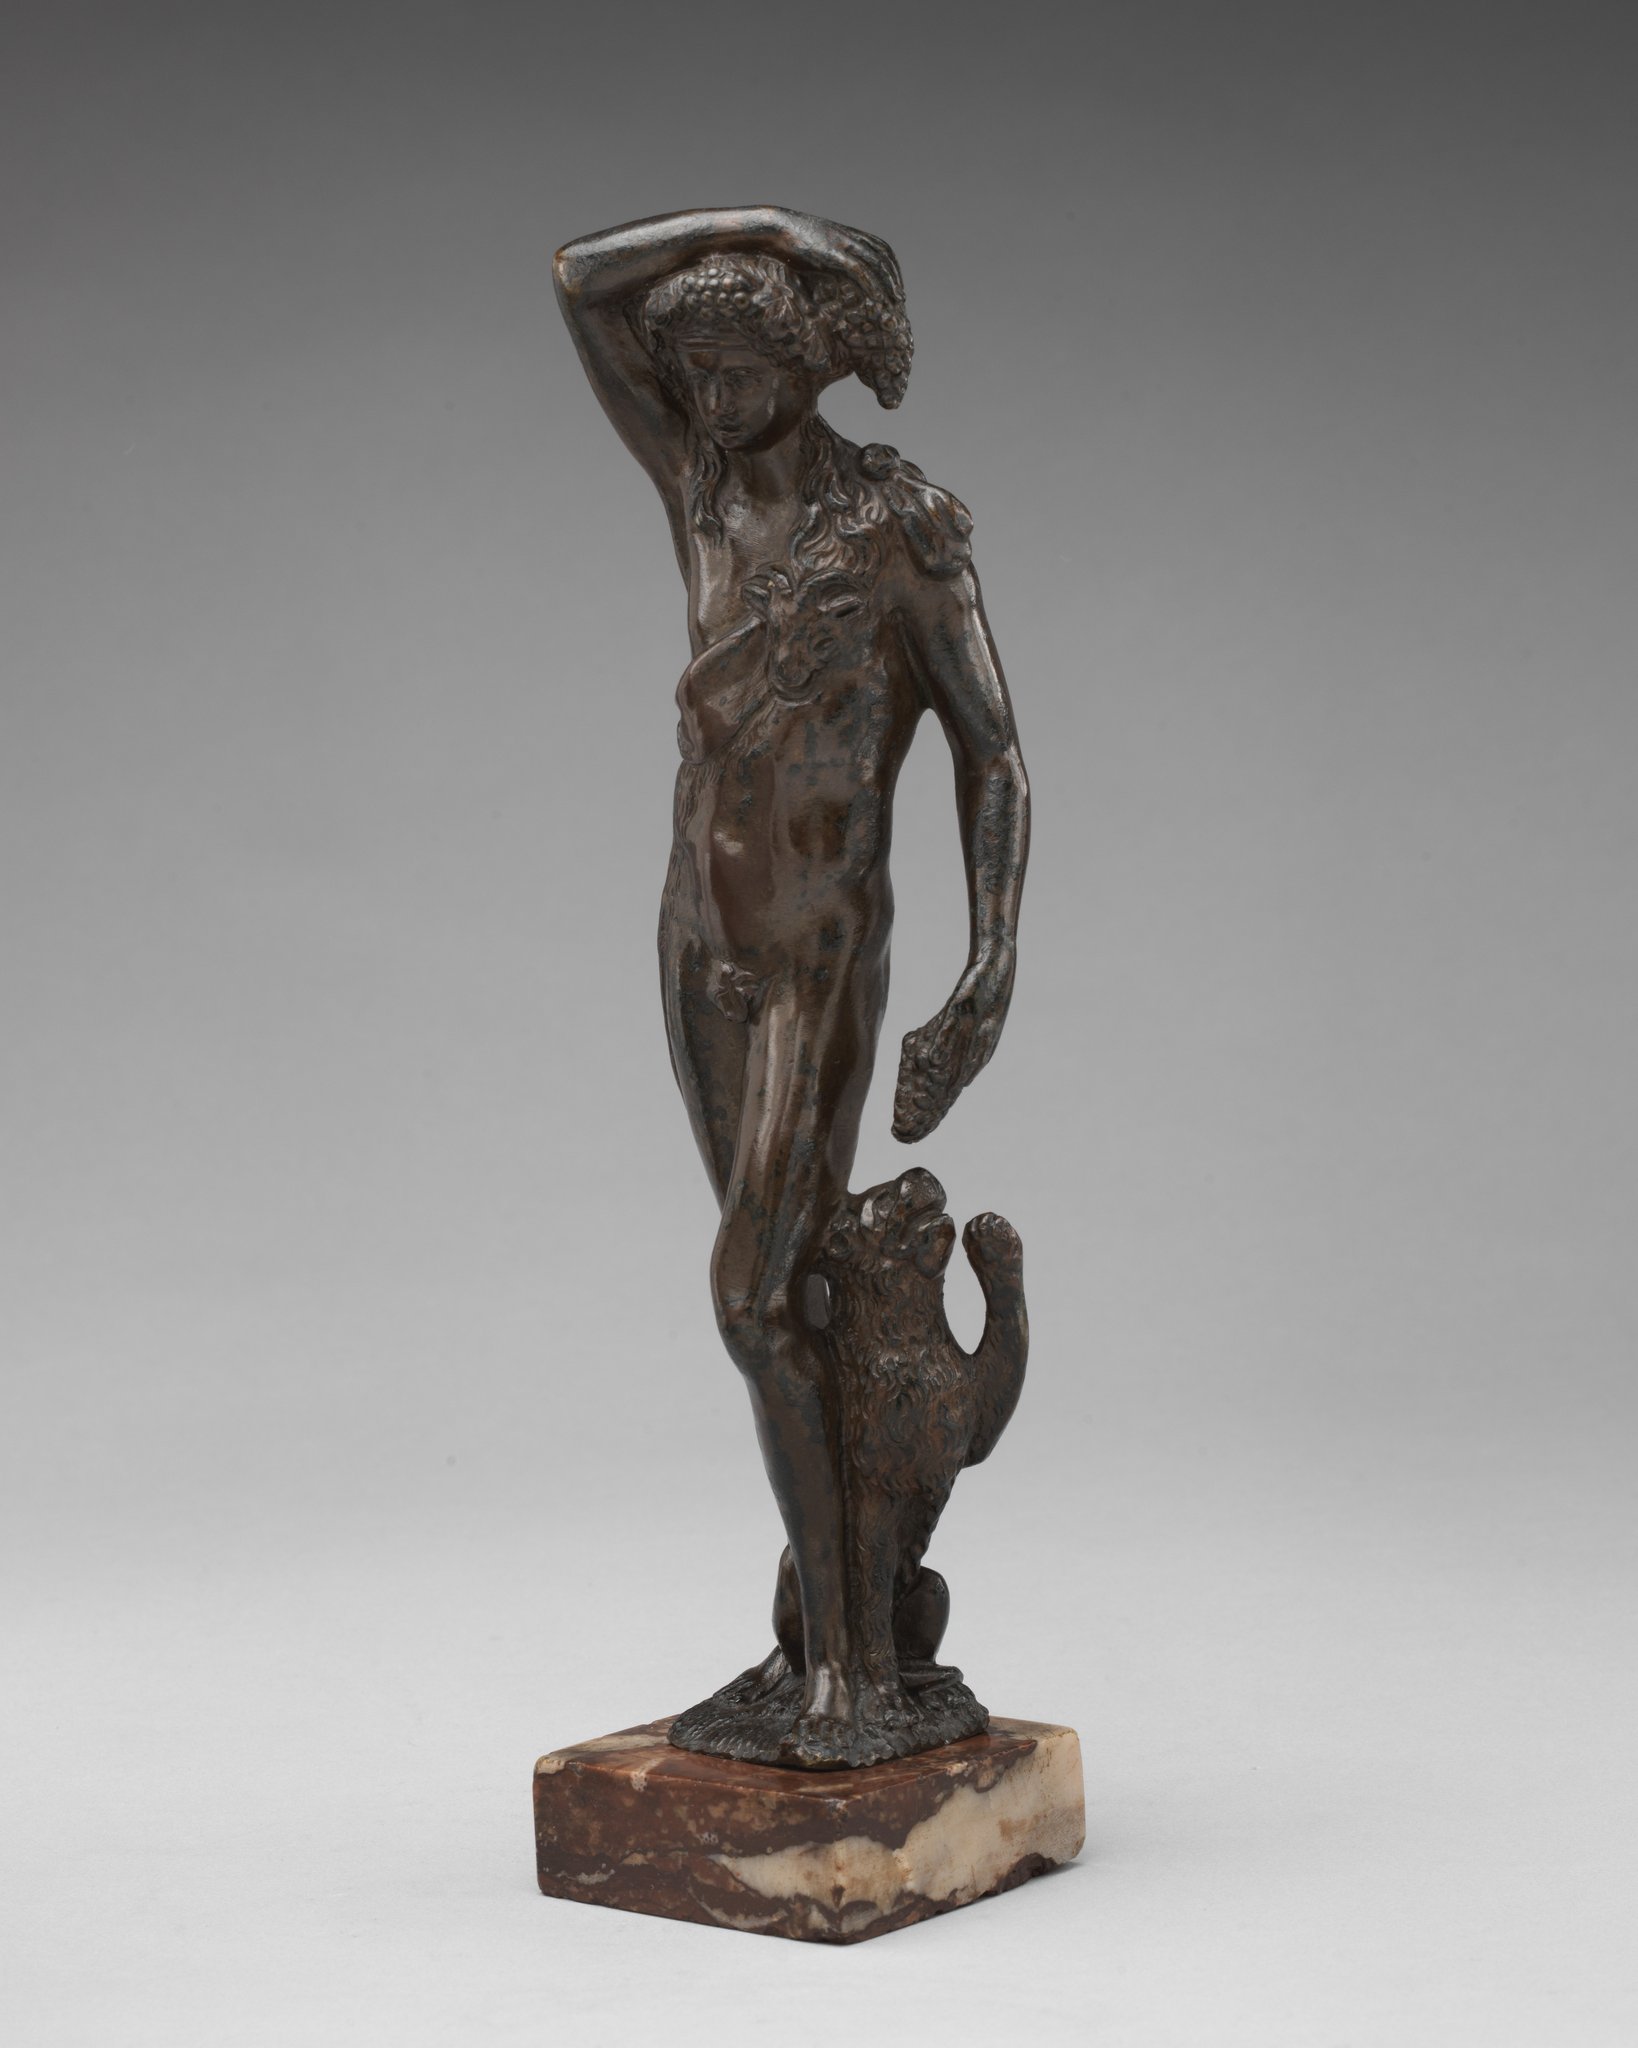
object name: statuette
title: Bacchus with a Panther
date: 1501-1700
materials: bronze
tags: bacchus,leopards